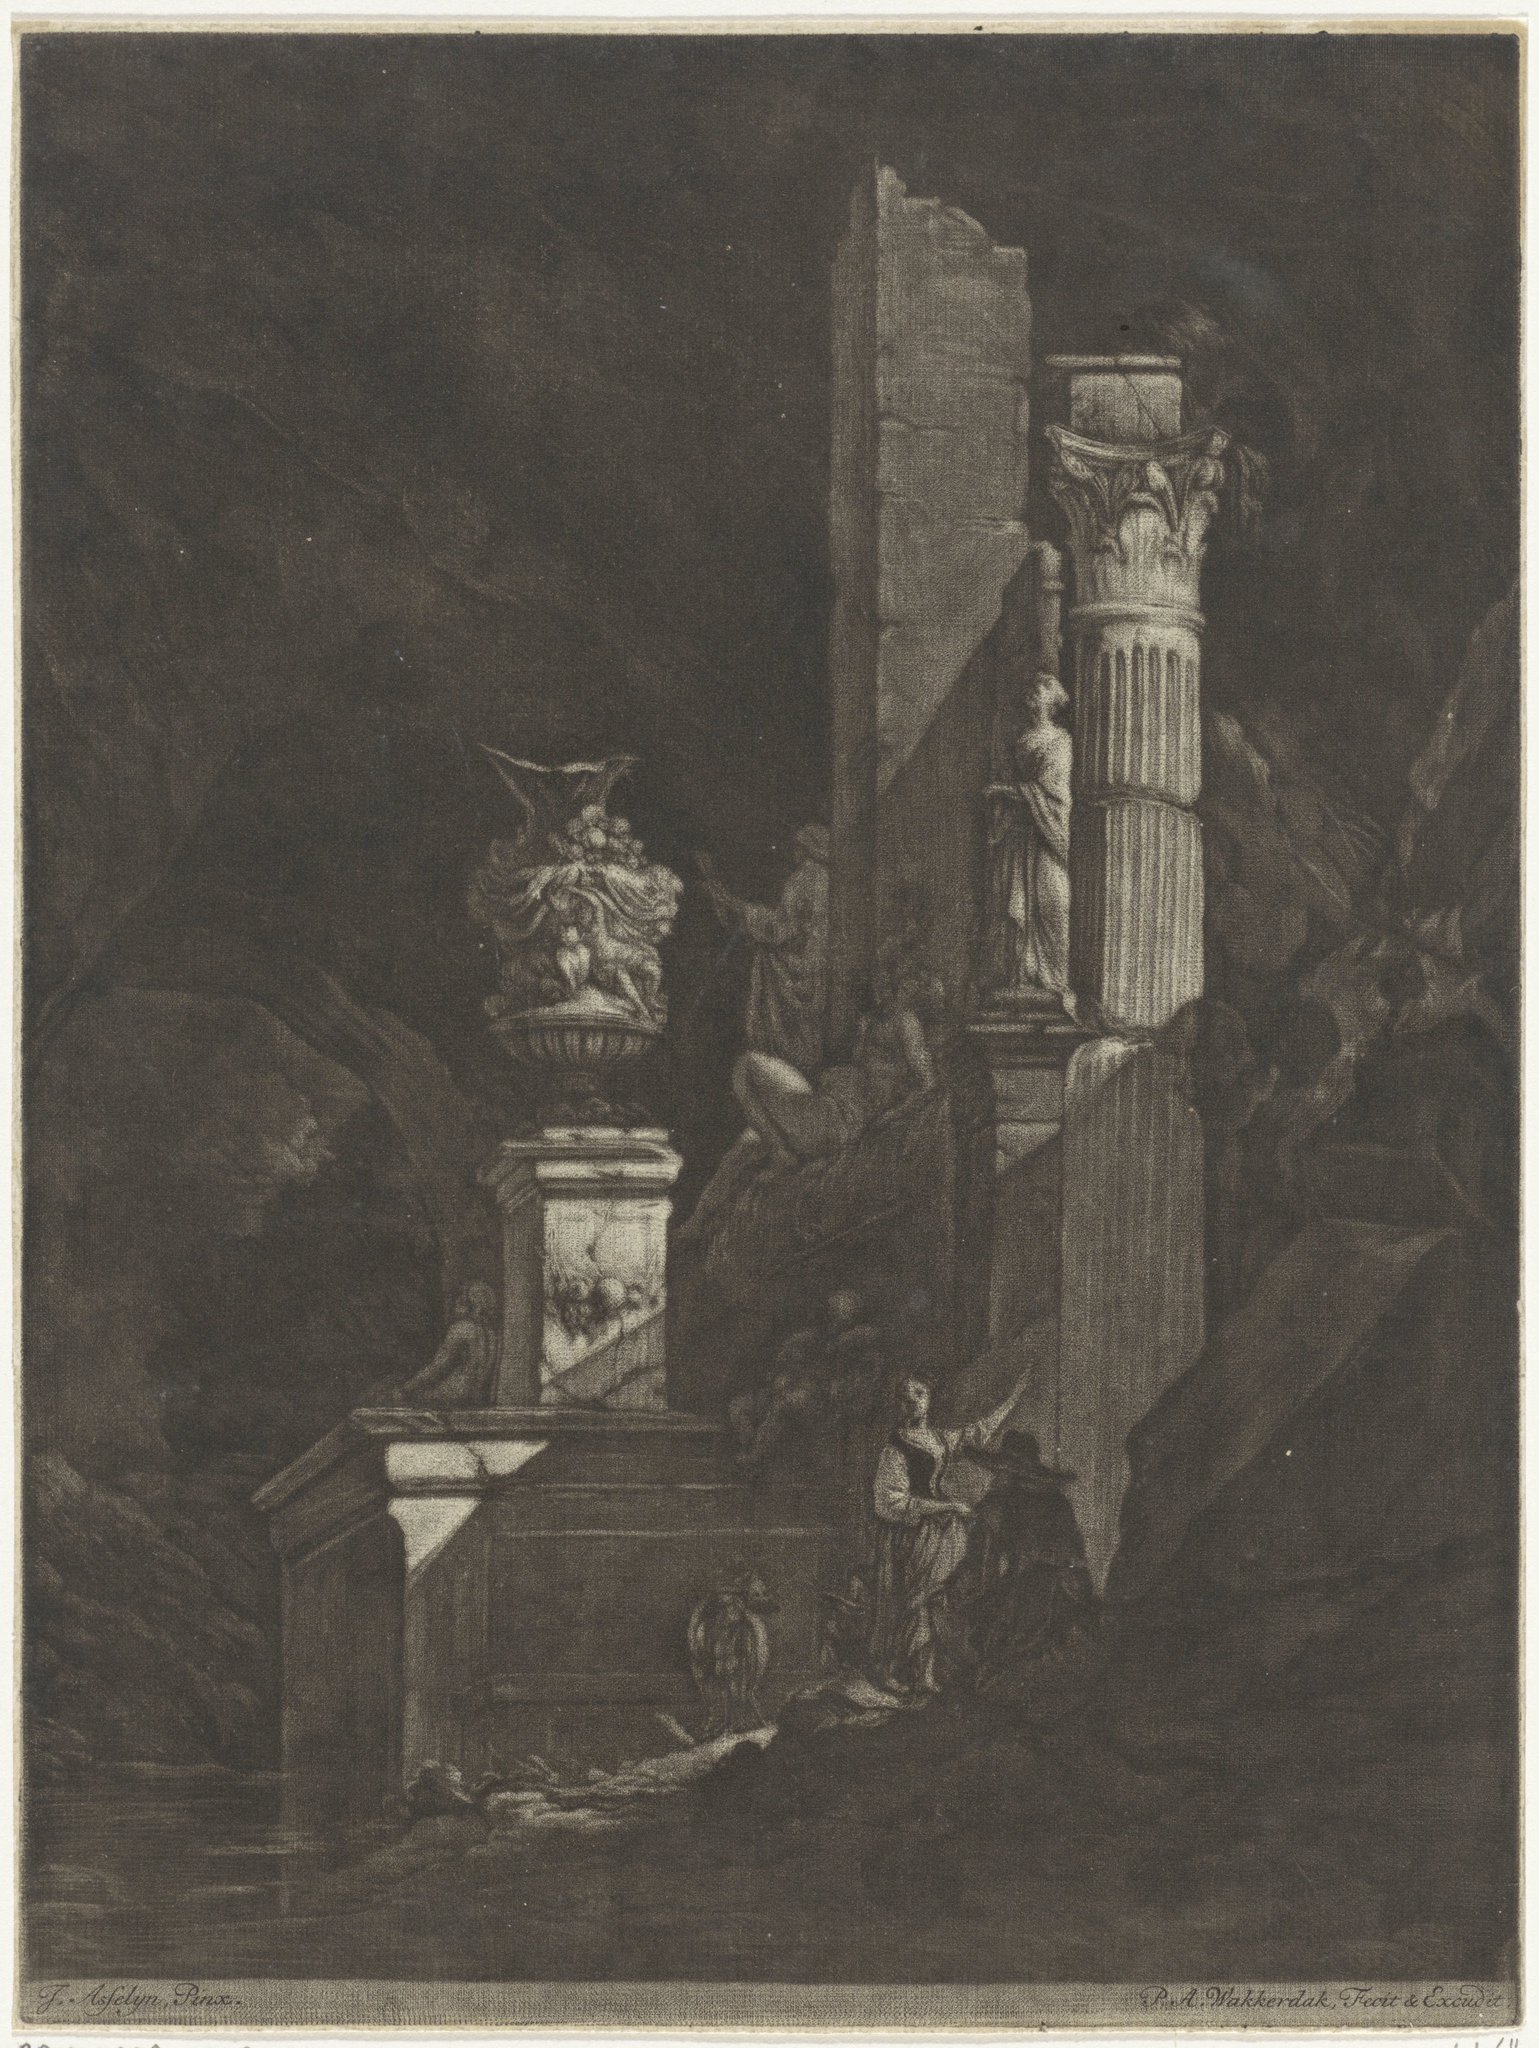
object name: print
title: Klassieke ruïnes in een grot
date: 1740-1774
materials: paper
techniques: mezzotint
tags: herding, herdsman, herdswoman, shepherd, shepherdess, cowherd, etc., ruin of a building ~ architecture, cave, grotto, dog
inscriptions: collector's mark: Lugt 2760, collector's mark: Lugt 2228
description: Twee herders en een herderin met een hond bevinden zich in een grot bij klassieke ruïnes.